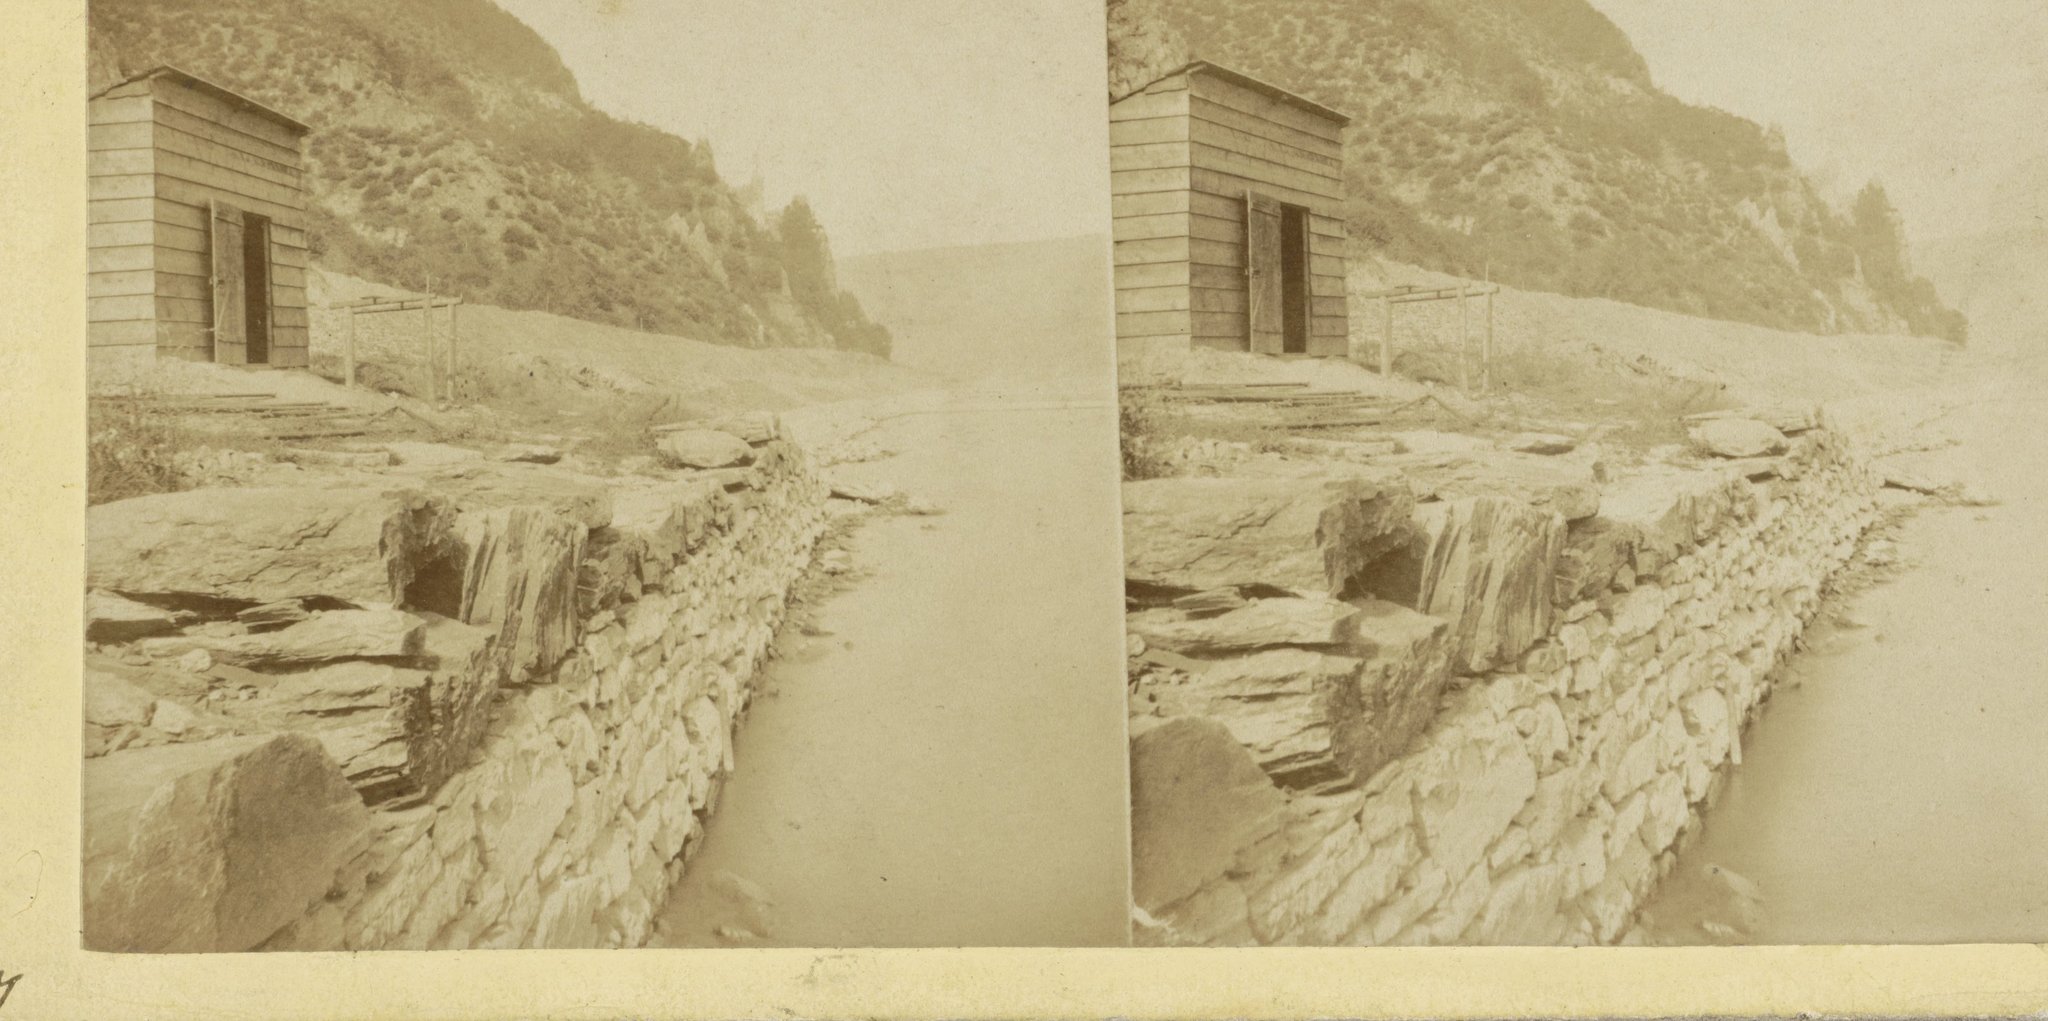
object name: stereograph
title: Panorama du Rheinstein, à Bengen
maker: Anonymous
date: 1861-1870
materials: cardboard, paper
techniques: albumen print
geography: bingen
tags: river bank, shed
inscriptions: number: ‘No 99’, inscription: ‘14’, inscription: ‘45 Ct’